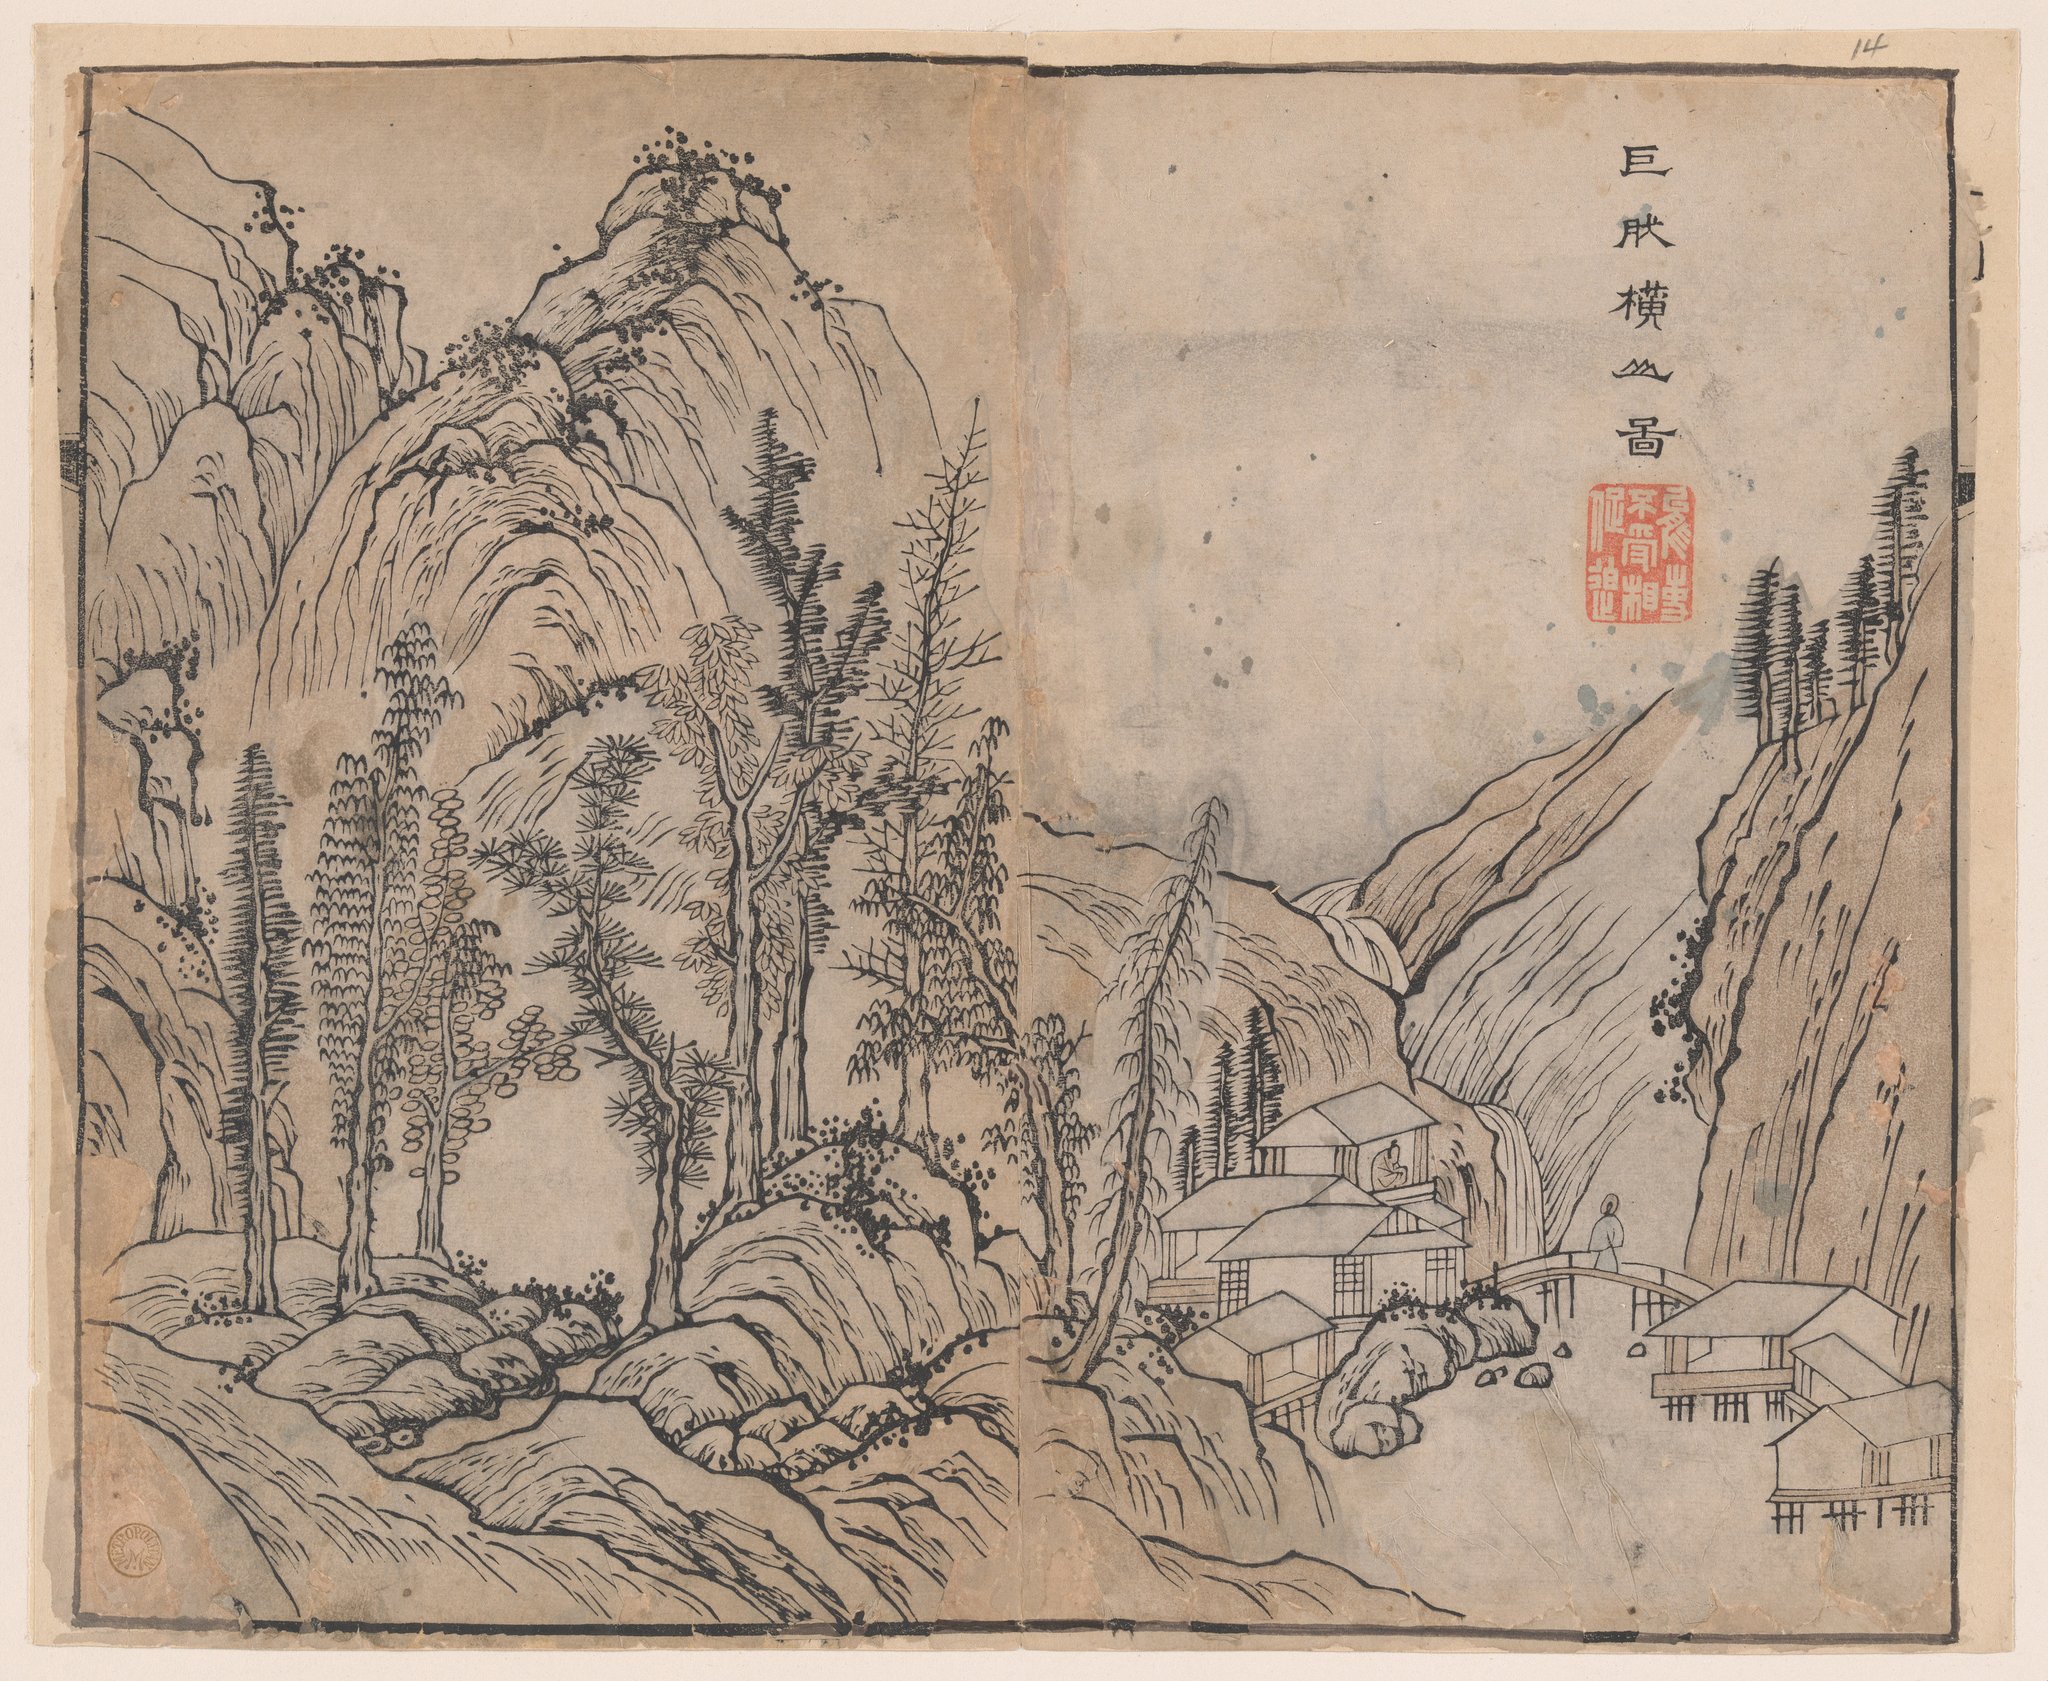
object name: print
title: Page from the Mustard Seed Garden Manual of Painting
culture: chinese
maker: wang gai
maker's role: artist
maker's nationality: chinese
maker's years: 1645-1710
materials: ink, paper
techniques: woodblock print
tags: mountains,landscapes